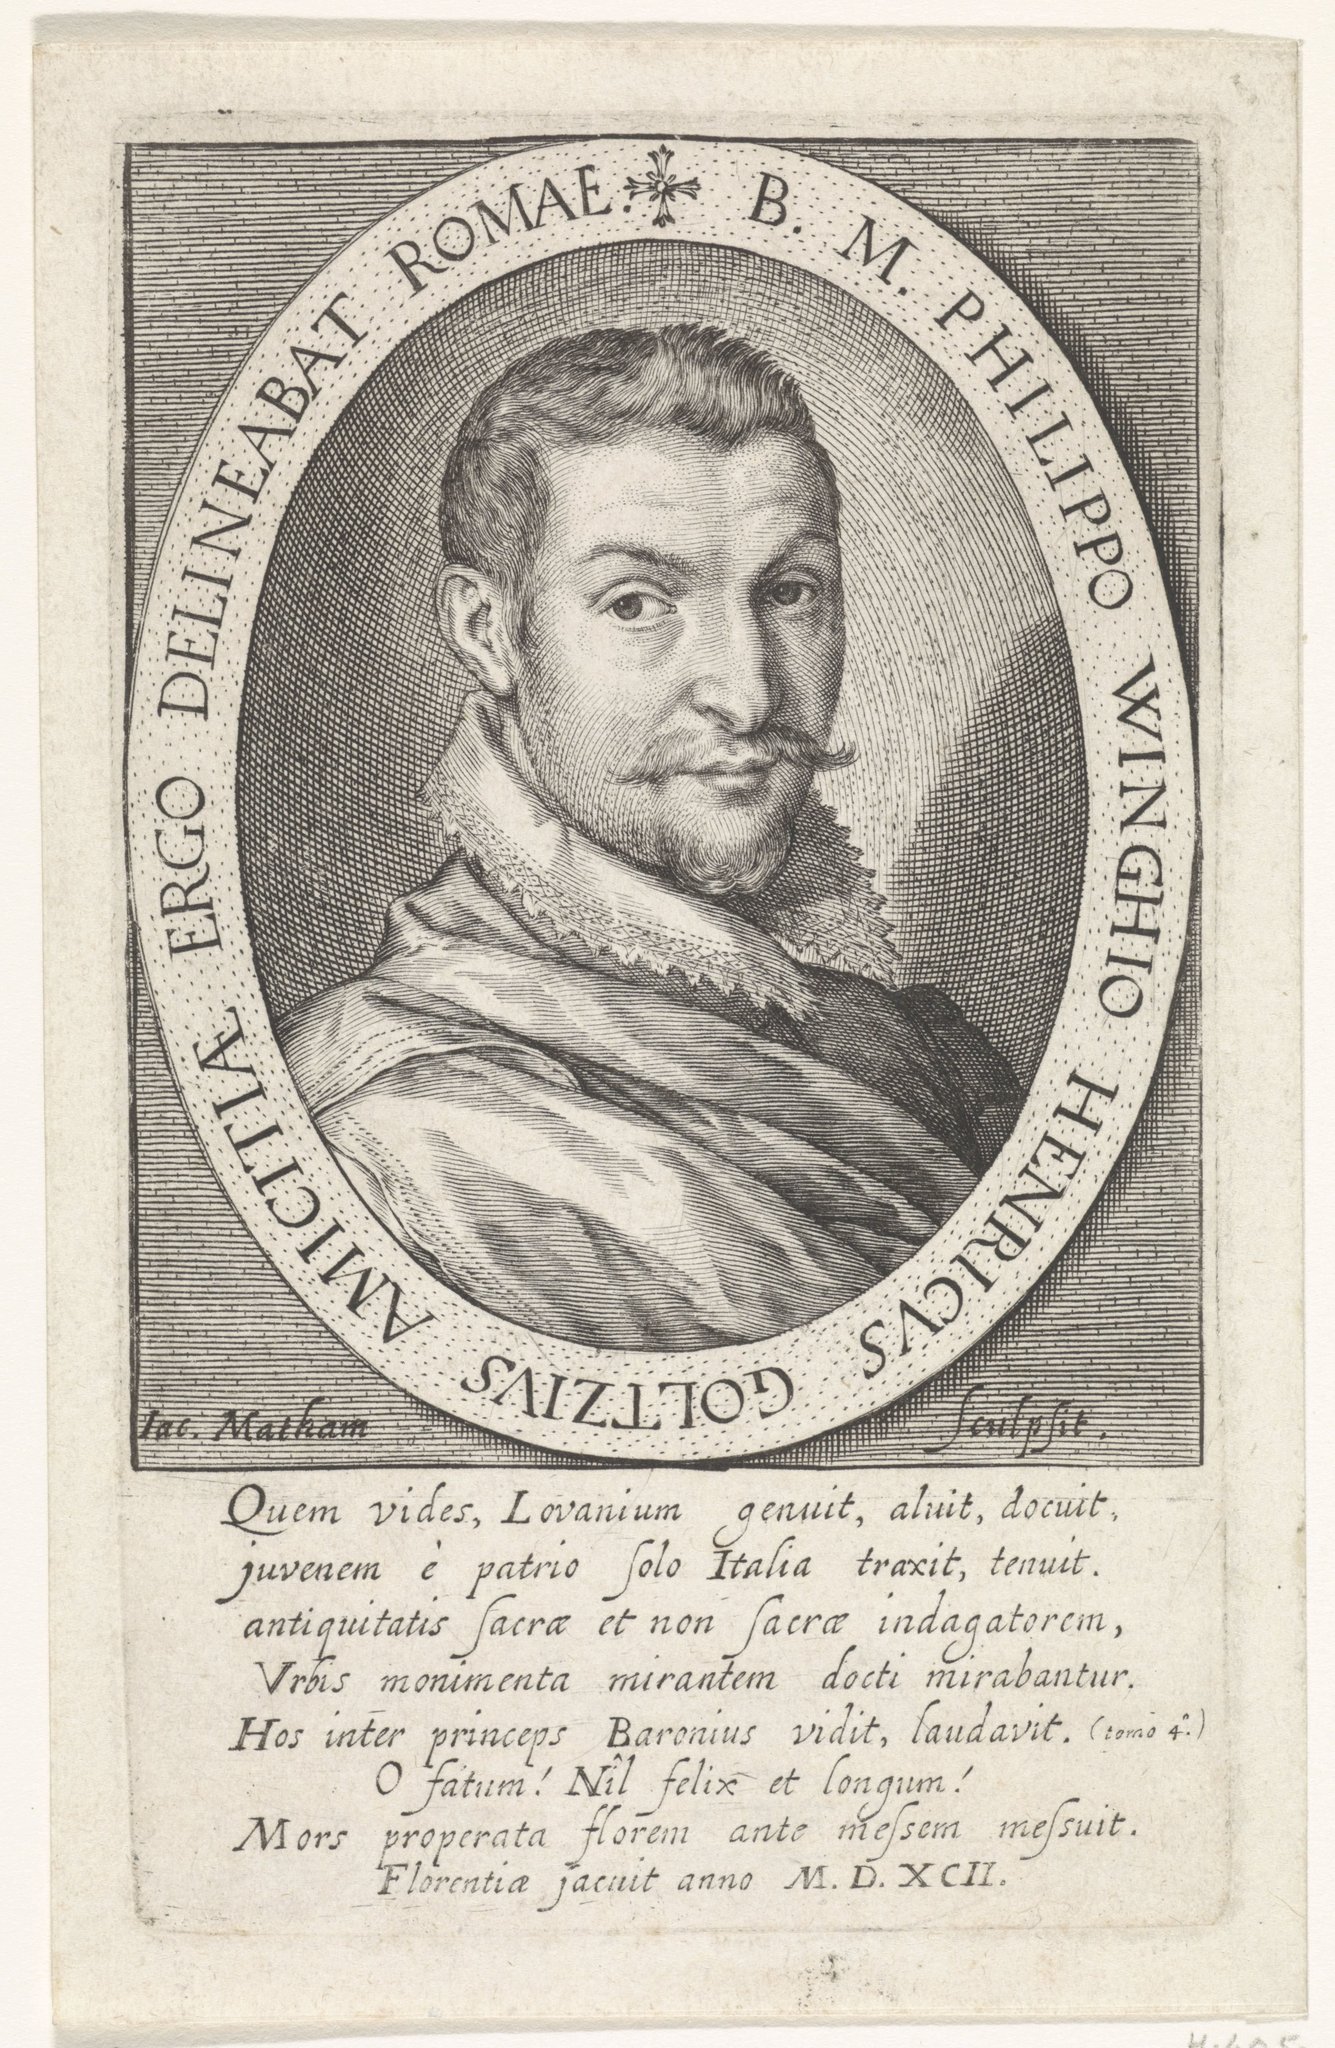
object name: print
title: Portret van Philips van Winghe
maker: jacob matham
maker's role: draughtsman, print maker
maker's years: 1571-1631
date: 1592-1597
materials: paper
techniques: engraving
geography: haarlem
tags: louvain, historical persons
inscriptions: collector's mark: Lugt 2228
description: Portret van de kunstliefhebber en vriend van Hendrick Goltzius, Philips van Winghe.